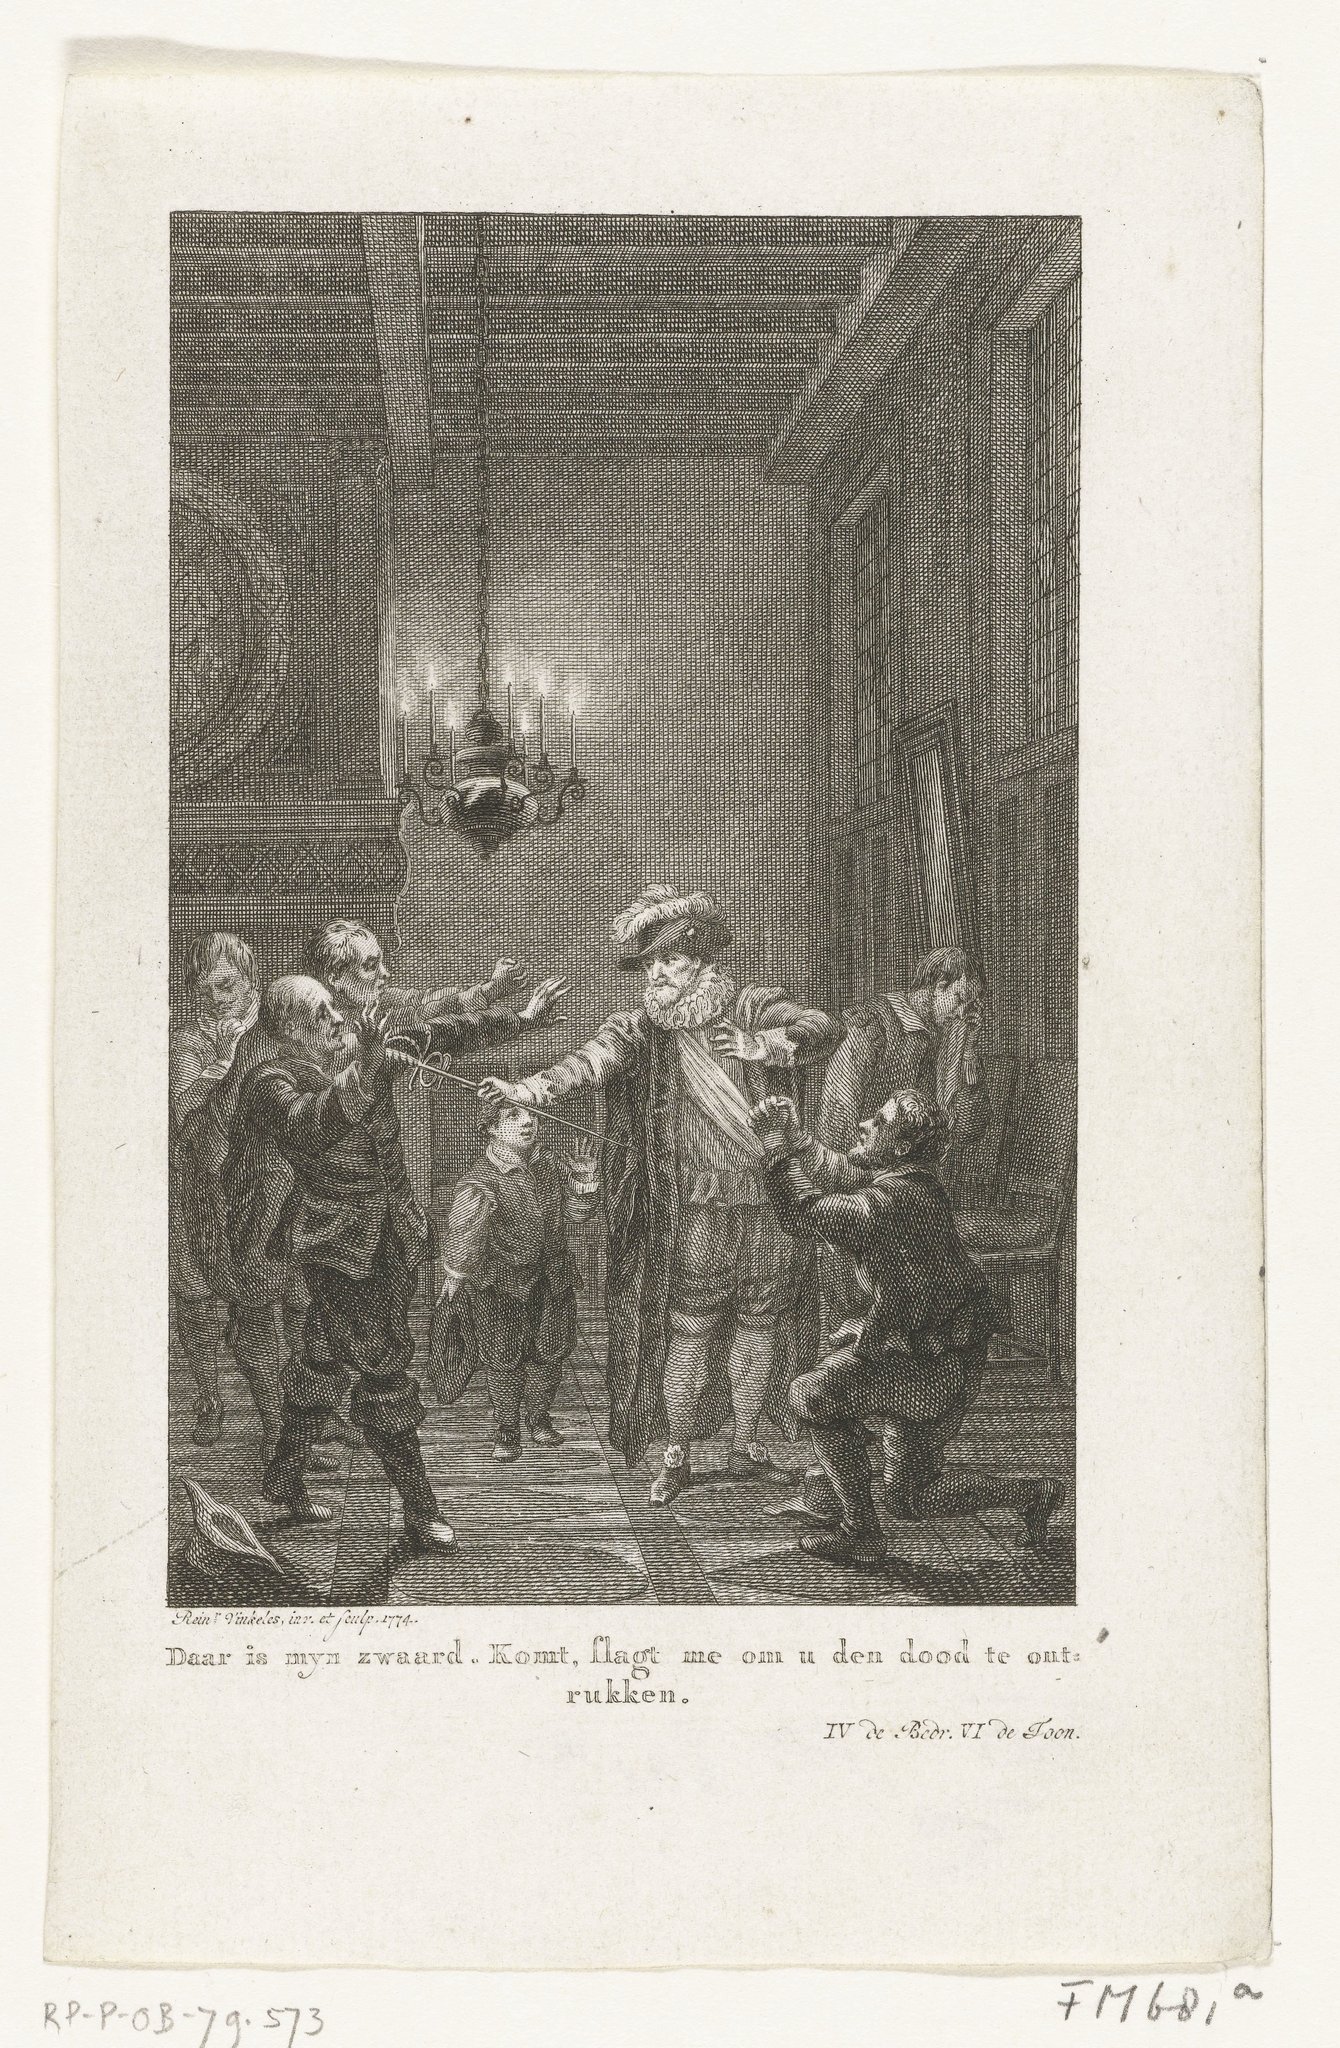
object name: history print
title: De zelfopoffering van burgemeester Pieter van der Werff, 1574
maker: reinier vinkeles (i)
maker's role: draughtsman, print maker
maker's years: 1741-1816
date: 1774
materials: paper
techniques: etching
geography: netherlands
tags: mayor, leiden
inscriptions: date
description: De zelfopoffering van burgemeester Pieter van der Werff, tijdens het beleg van Leiden, 1574. Interieur met Van der Werff die omstanders het zwaard aanreikt, bij kaarslicht (klein formaat).